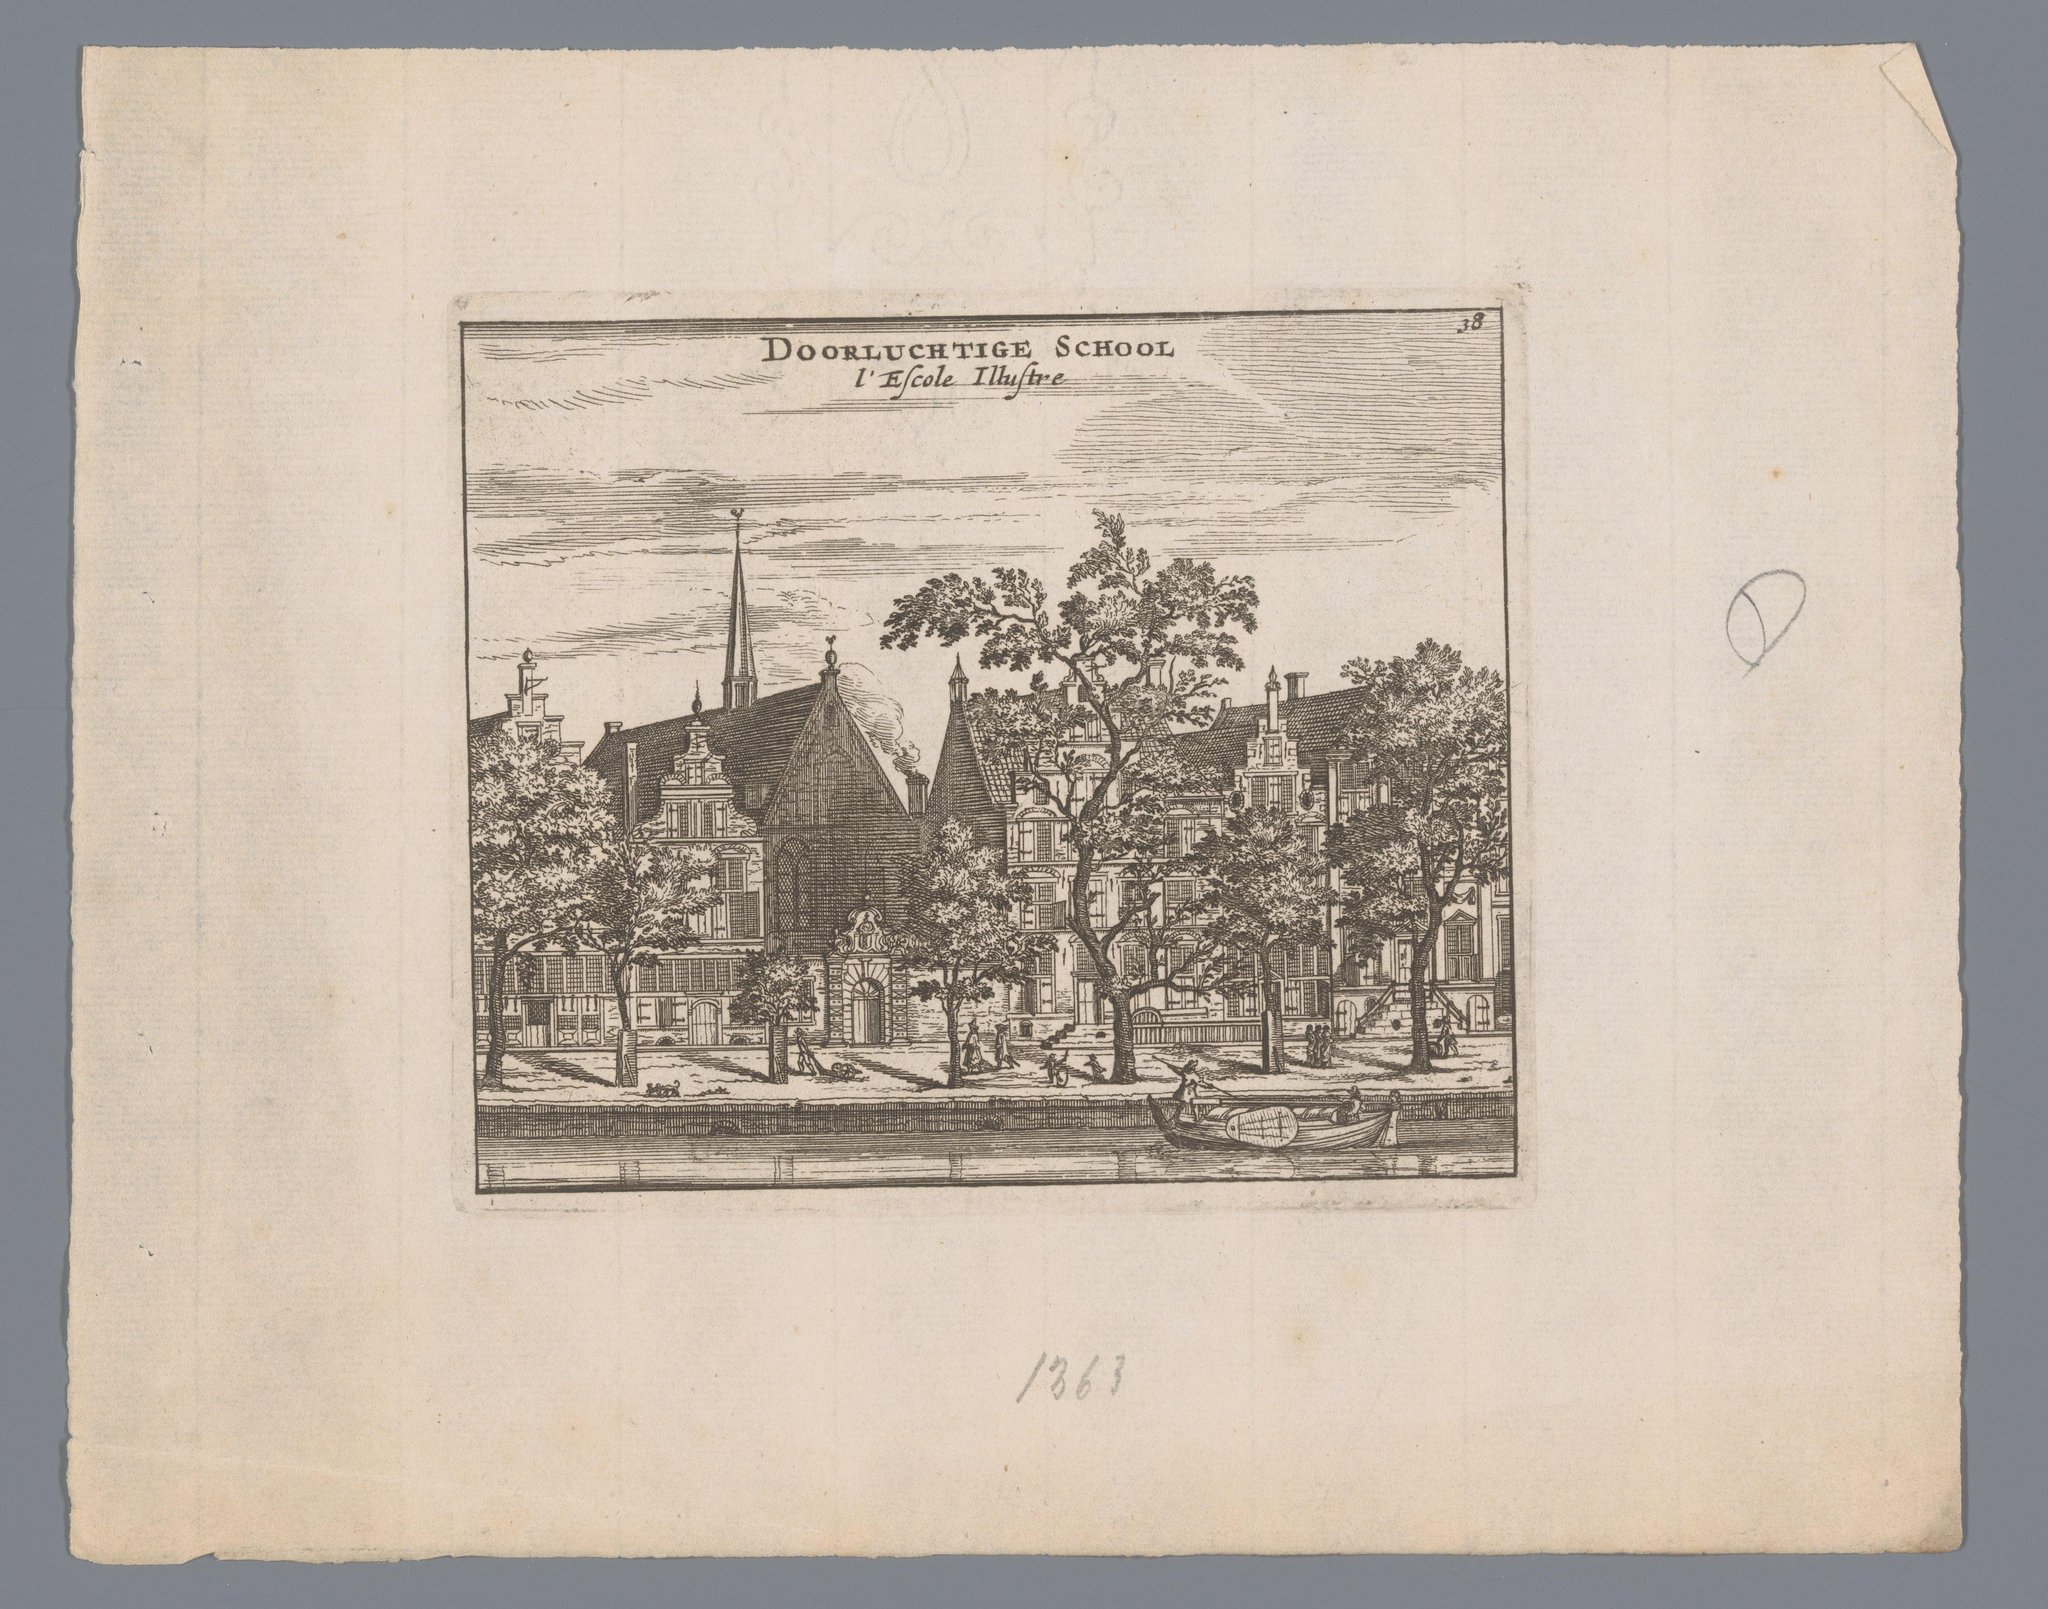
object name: print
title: De doorluchtige school / L'ecole illustre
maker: Anonymous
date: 1650-1750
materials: paper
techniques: etching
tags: names of organizations, companies, trade unions, etc., poling, punting, canals, waters (in city), university building, college